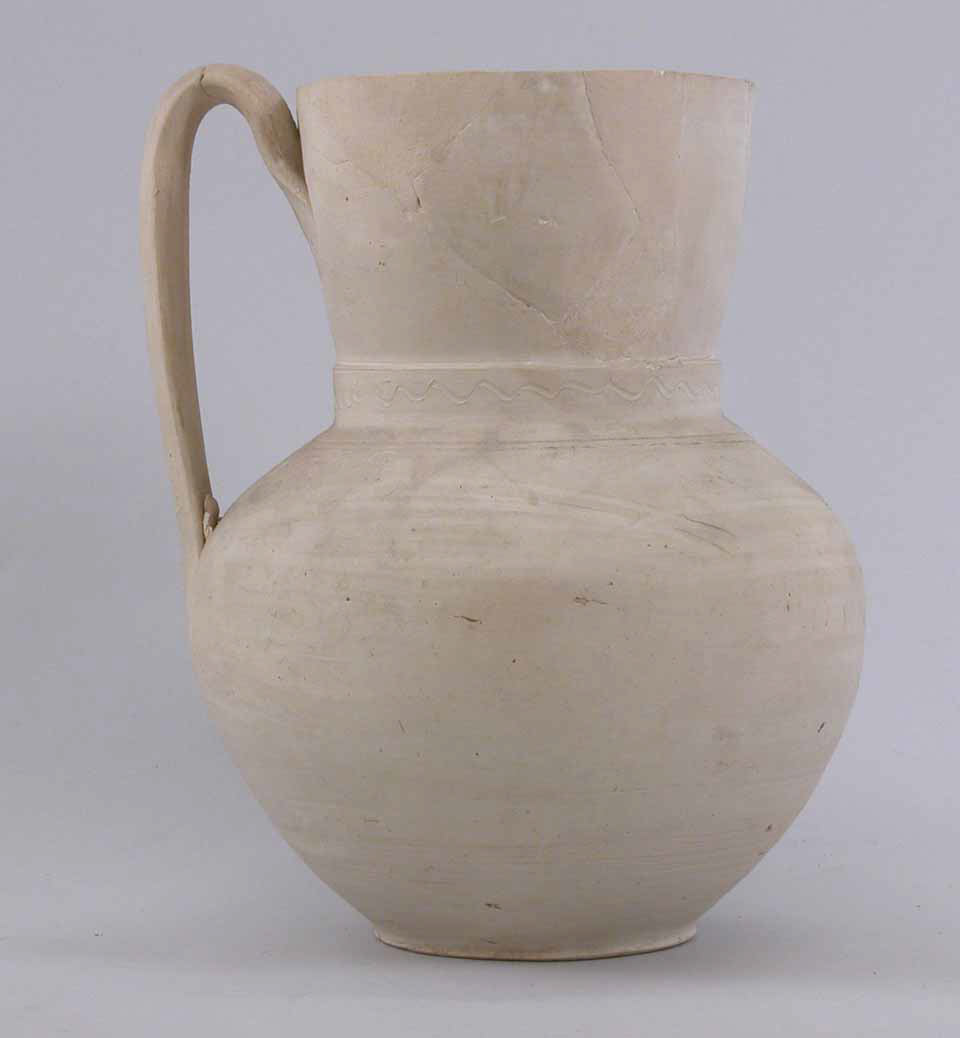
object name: ewer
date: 801-900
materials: earthenware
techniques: incising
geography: iran